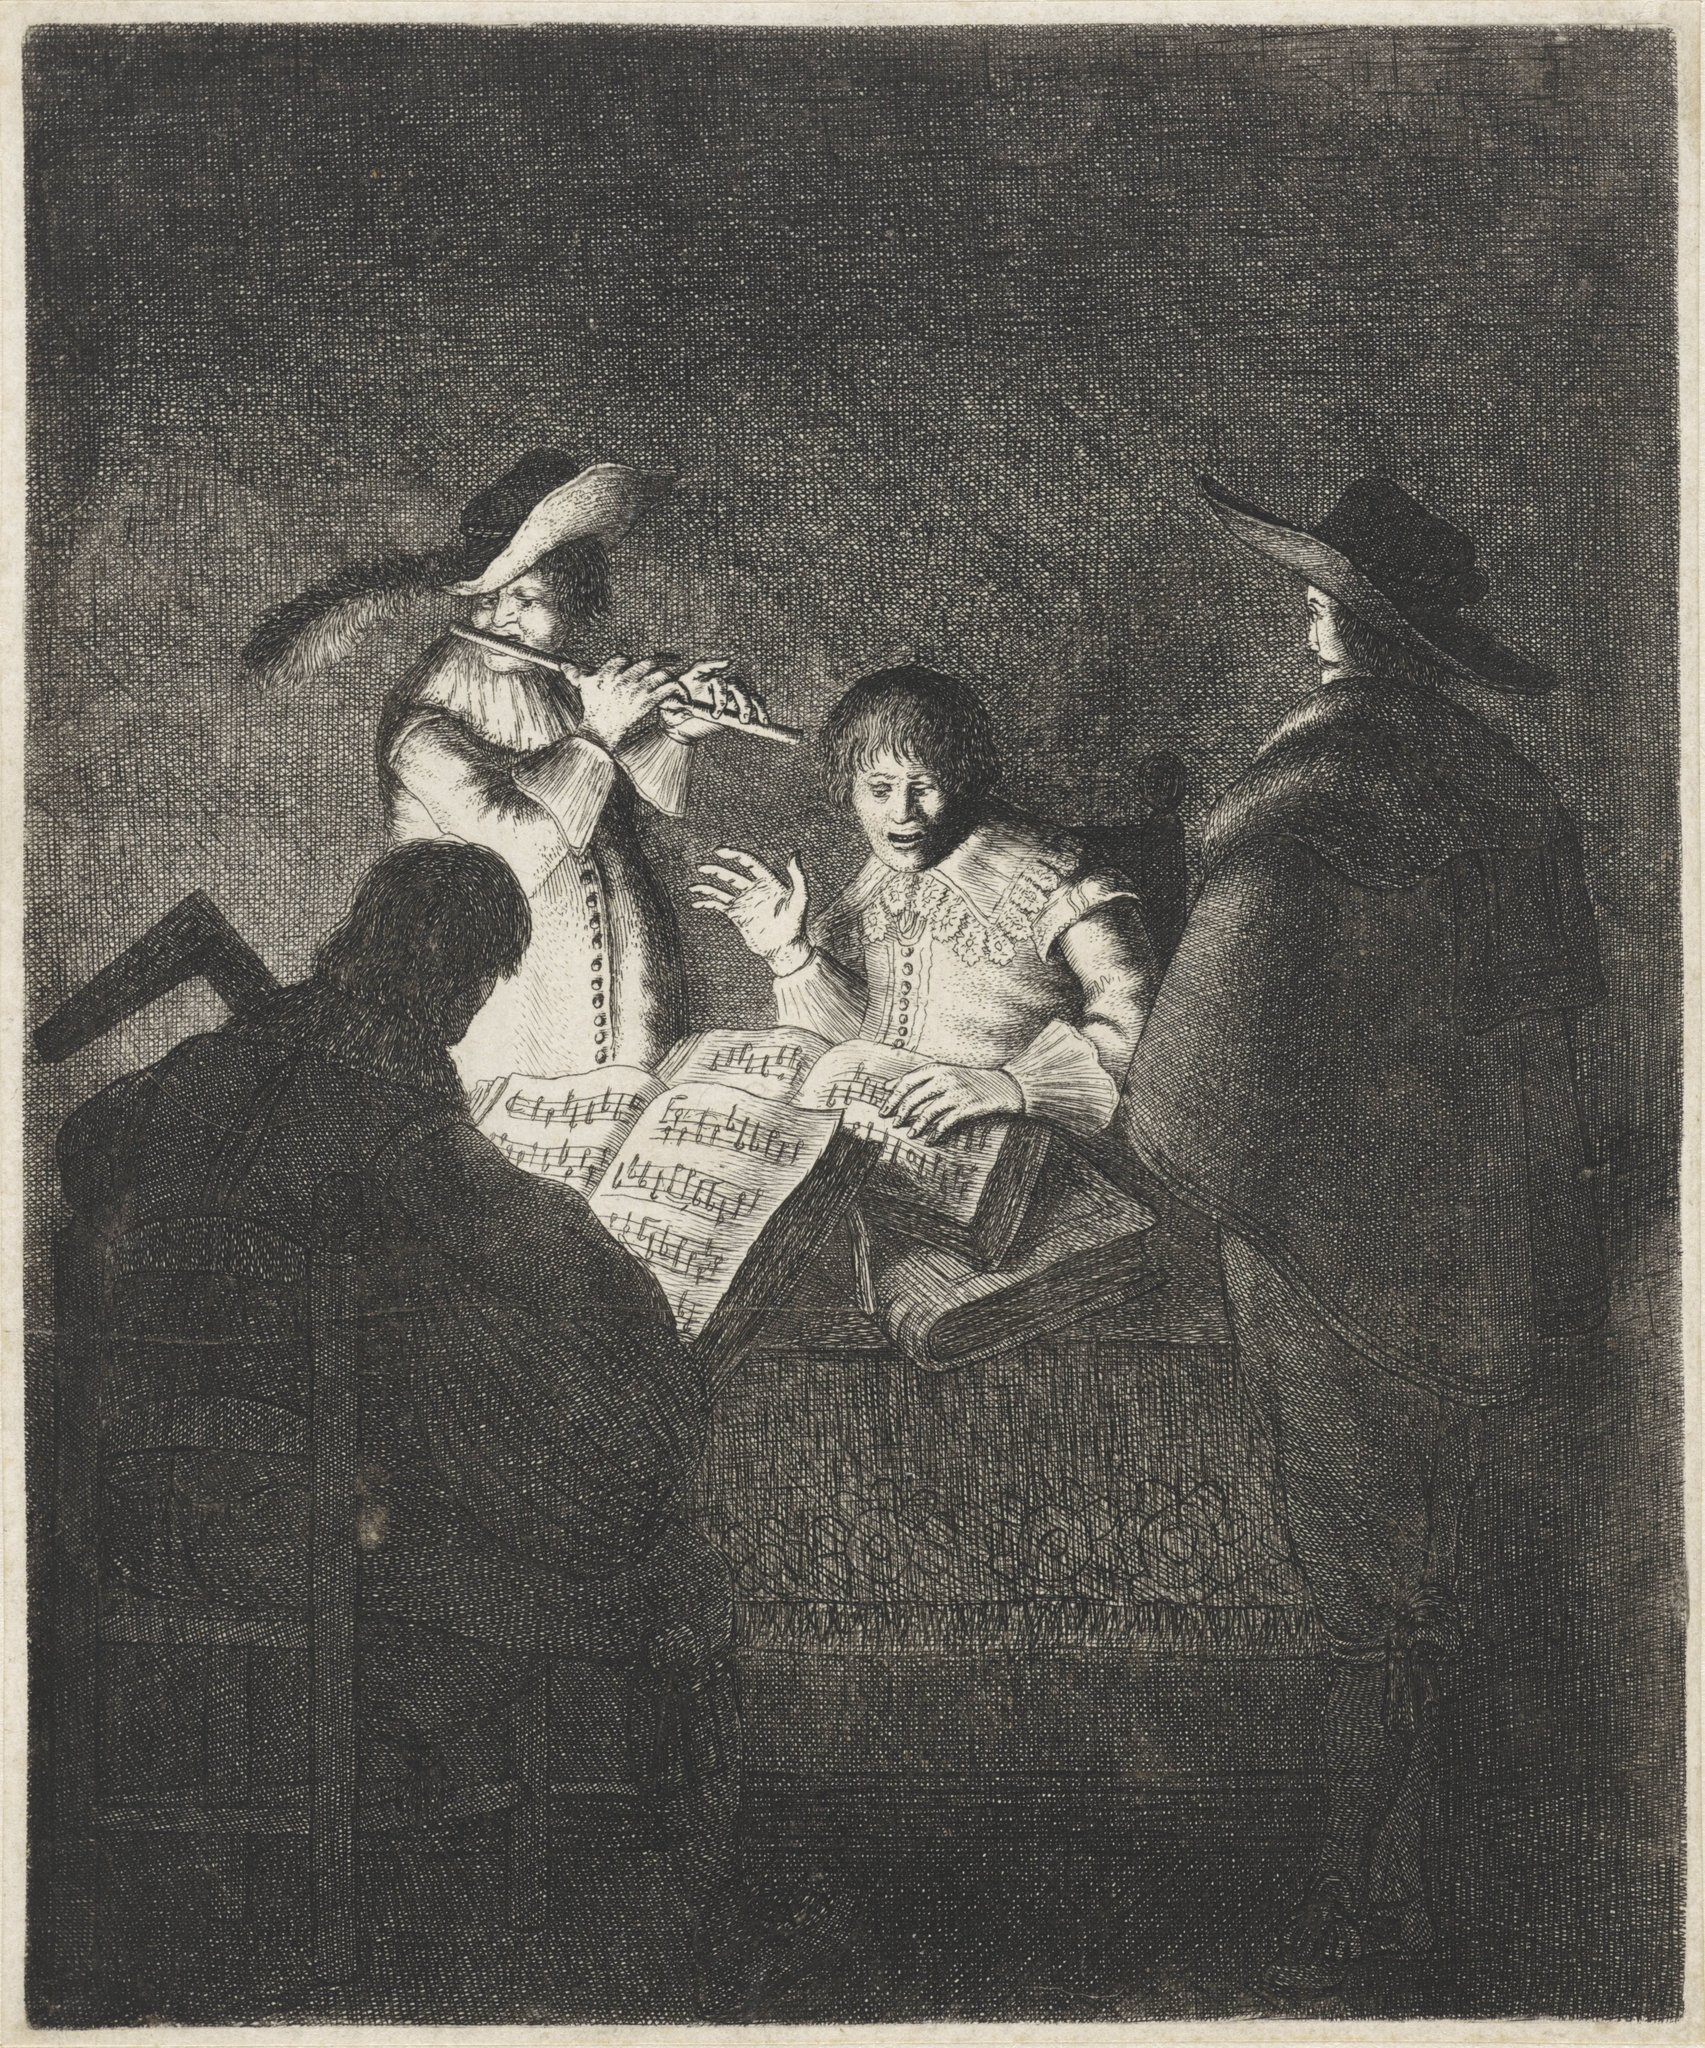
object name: print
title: Musicerend gezelschap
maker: jan gillisz. van vliet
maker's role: draughtsman, painter, print maker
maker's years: 1600-1668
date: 1634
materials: paper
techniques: engraving, etching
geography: leiden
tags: notation of music, musical instruments; group of musical instruments (+ artist at work), hearing, listening (one of the five senses), musician(s) accompanying singer(s)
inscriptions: collector's mark: ‘F.D. 1839’ Lugt 985, inscription: ‘de Cl no.28’, collector's mark: Lugt 2228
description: In een interieur staat een man bij een musicerend gezelschap. Een man op de rug gezien bespeelt een luit, een man bespeelt een dwarsfluit en een man zingt, rond een tafel waarop liedboeken.